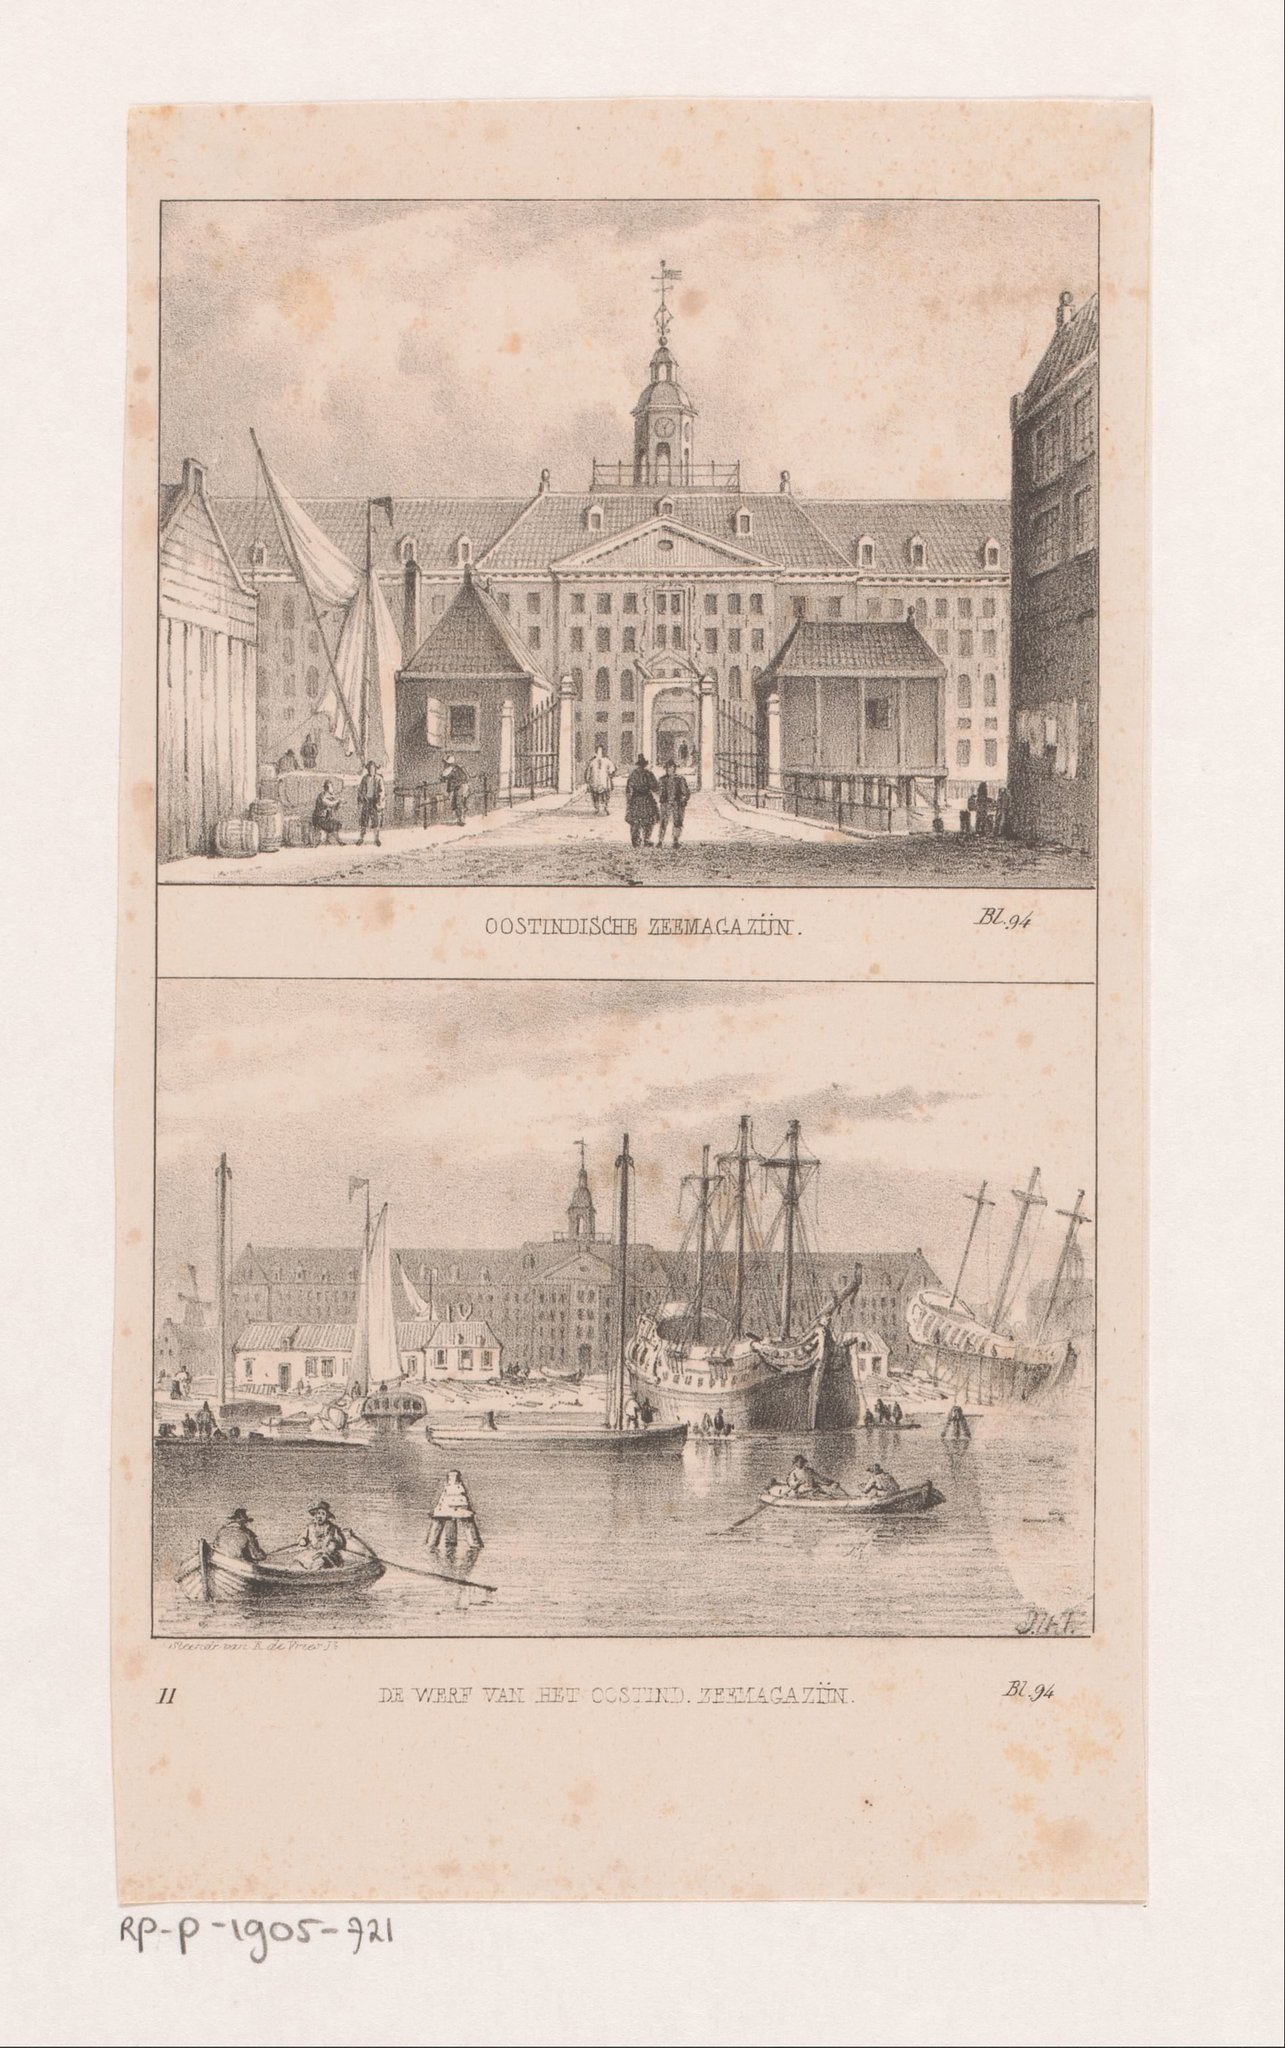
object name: book illustration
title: Oostindisch zeemagazijn en de werf in Amsterdam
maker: johannes hilverdink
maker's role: draughtsman, painter, print maker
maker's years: 1813-1902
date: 1823-1902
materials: paper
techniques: lithograph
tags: warehouse (~ harbour), shipyard, shipdock - cc - more than one ship, amsterdam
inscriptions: collector's mark: Lugt 2228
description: Deze illustratie is mogelijk afkomstig uit: Vijver, C. Geschiedkundige beschrijving der stad Amsterdam, sedert hare wording tot op den tegenwoordigen tijd, Amsterdam 18440-1848.